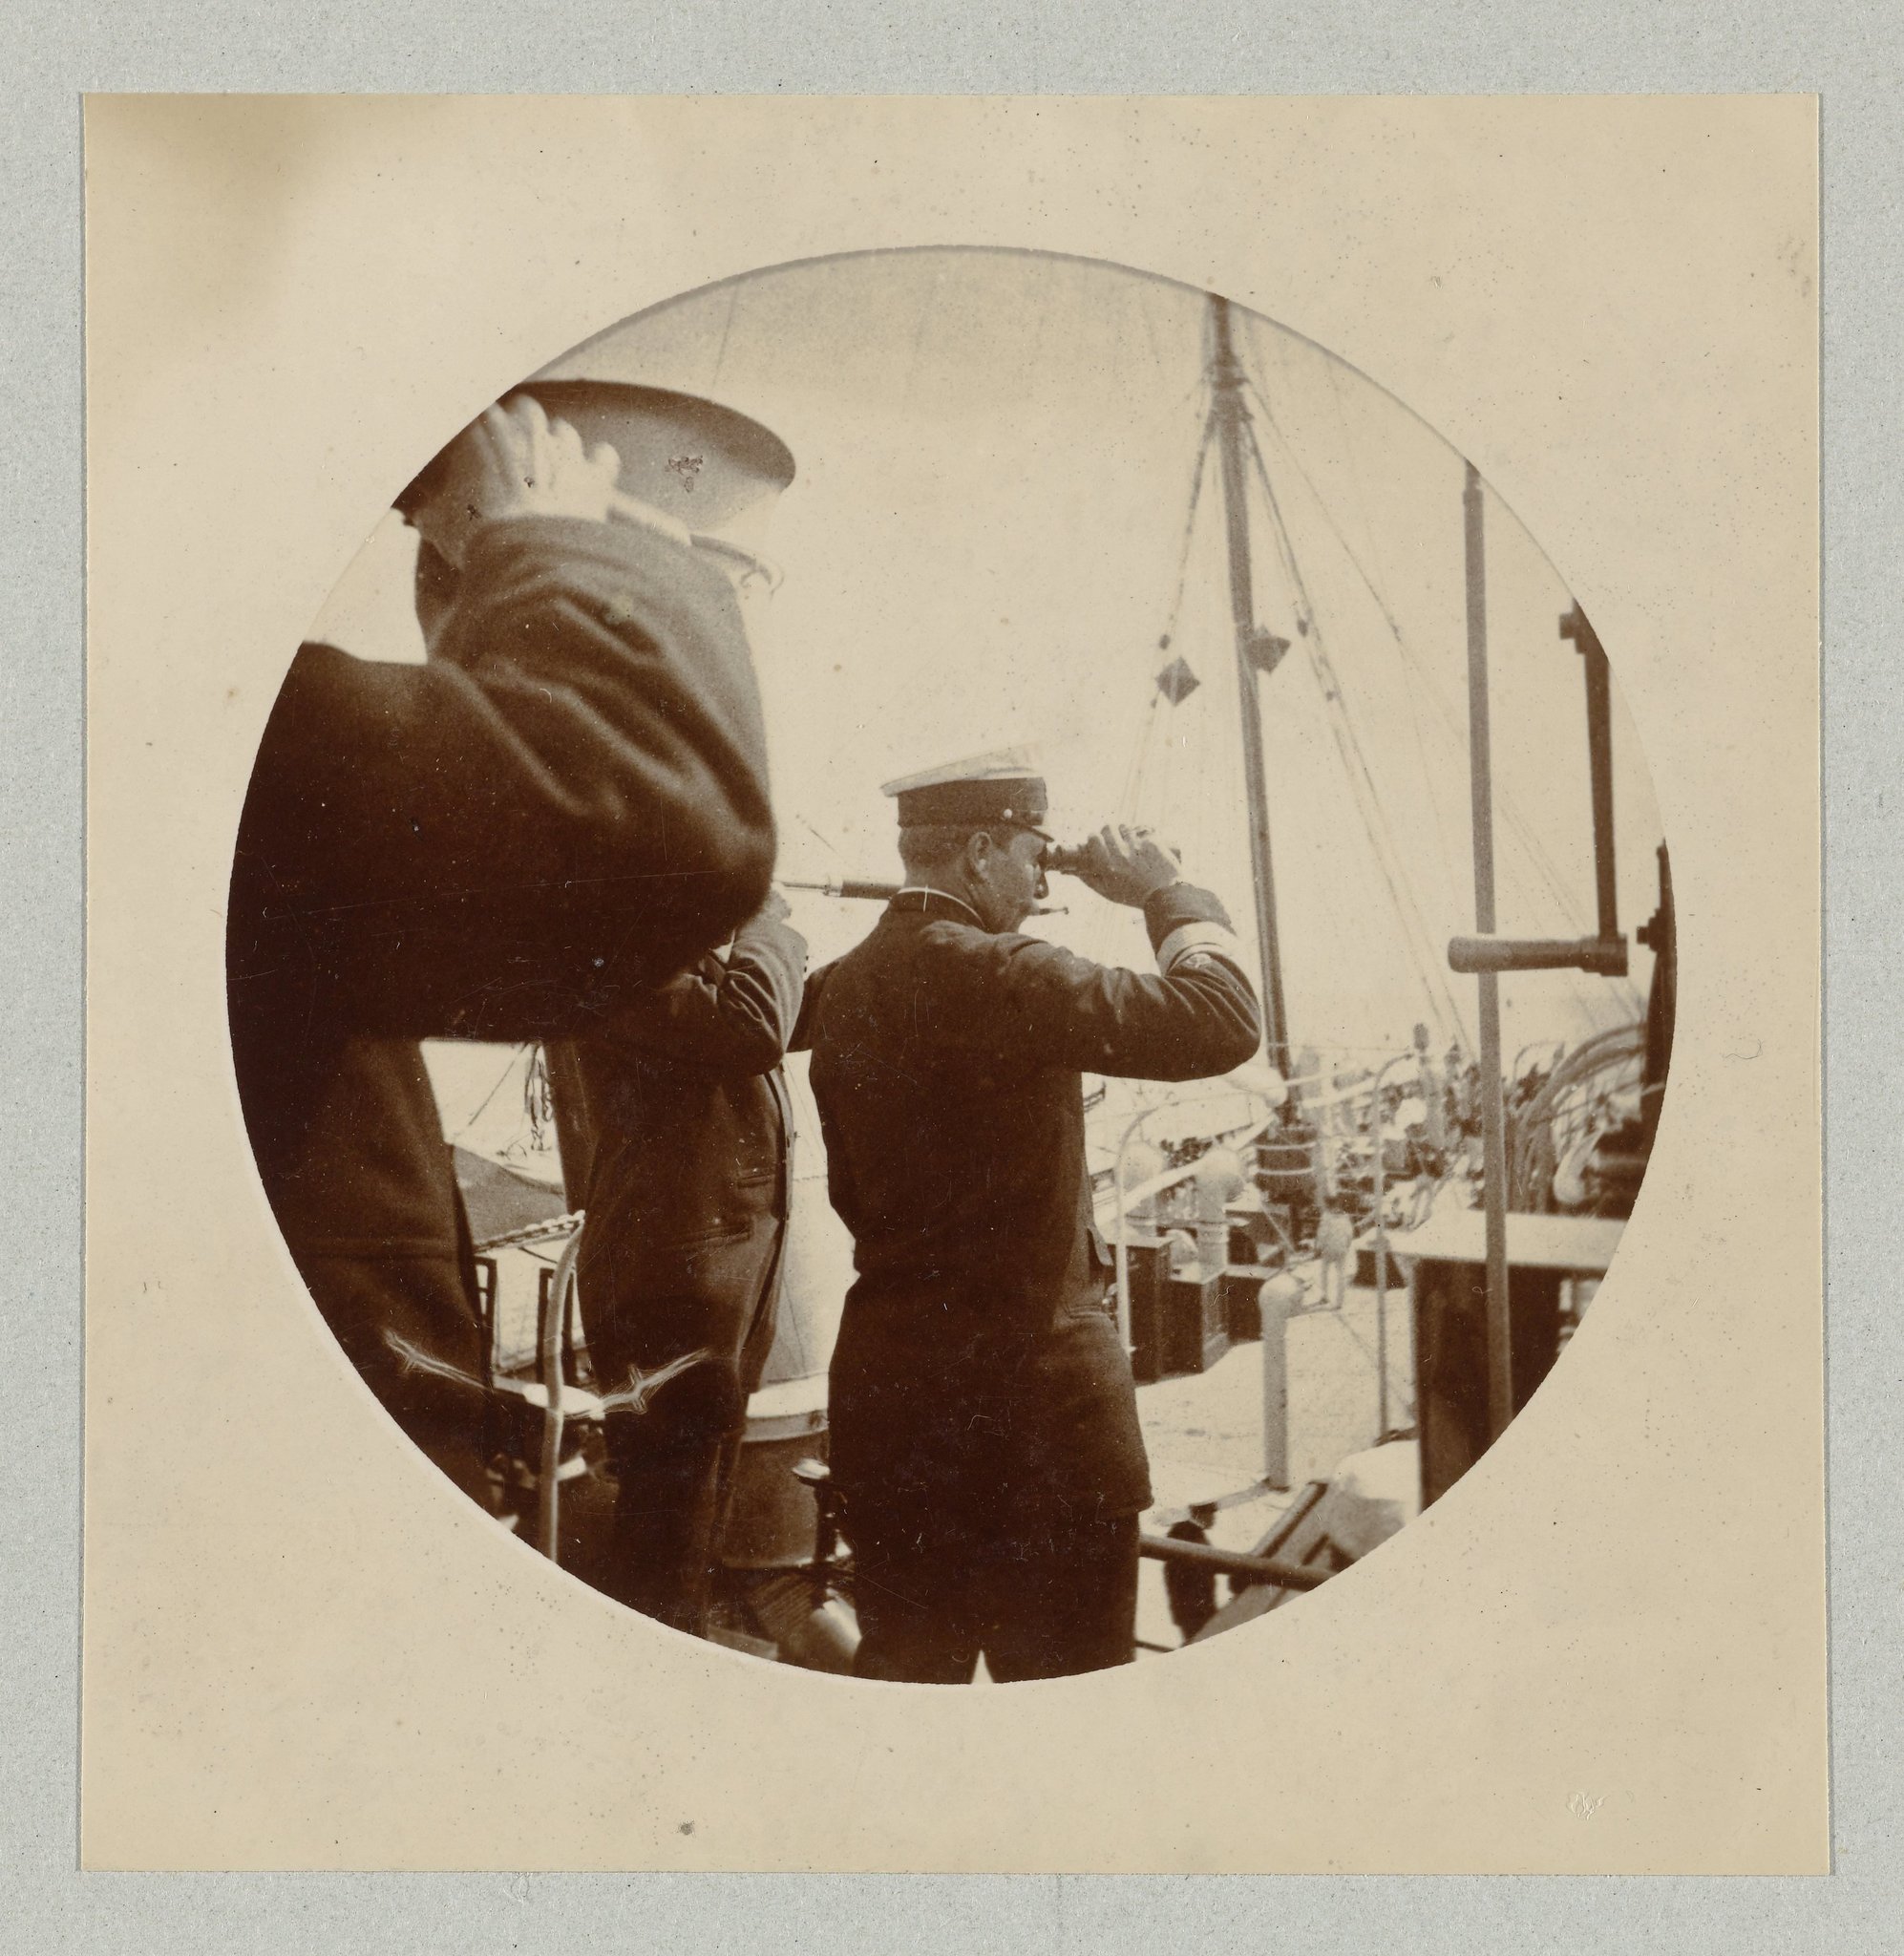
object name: photograph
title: Im Hafen von Bergen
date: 1807-1889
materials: cardboard, paper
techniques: gelatin silver print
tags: wilhelm ii (keizer van duitsland), norway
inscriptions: number: ‘12’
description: De afdruk van de foto is rond, het papier vierkant. foto gemaakt met Nr. 1 Kodak Camera